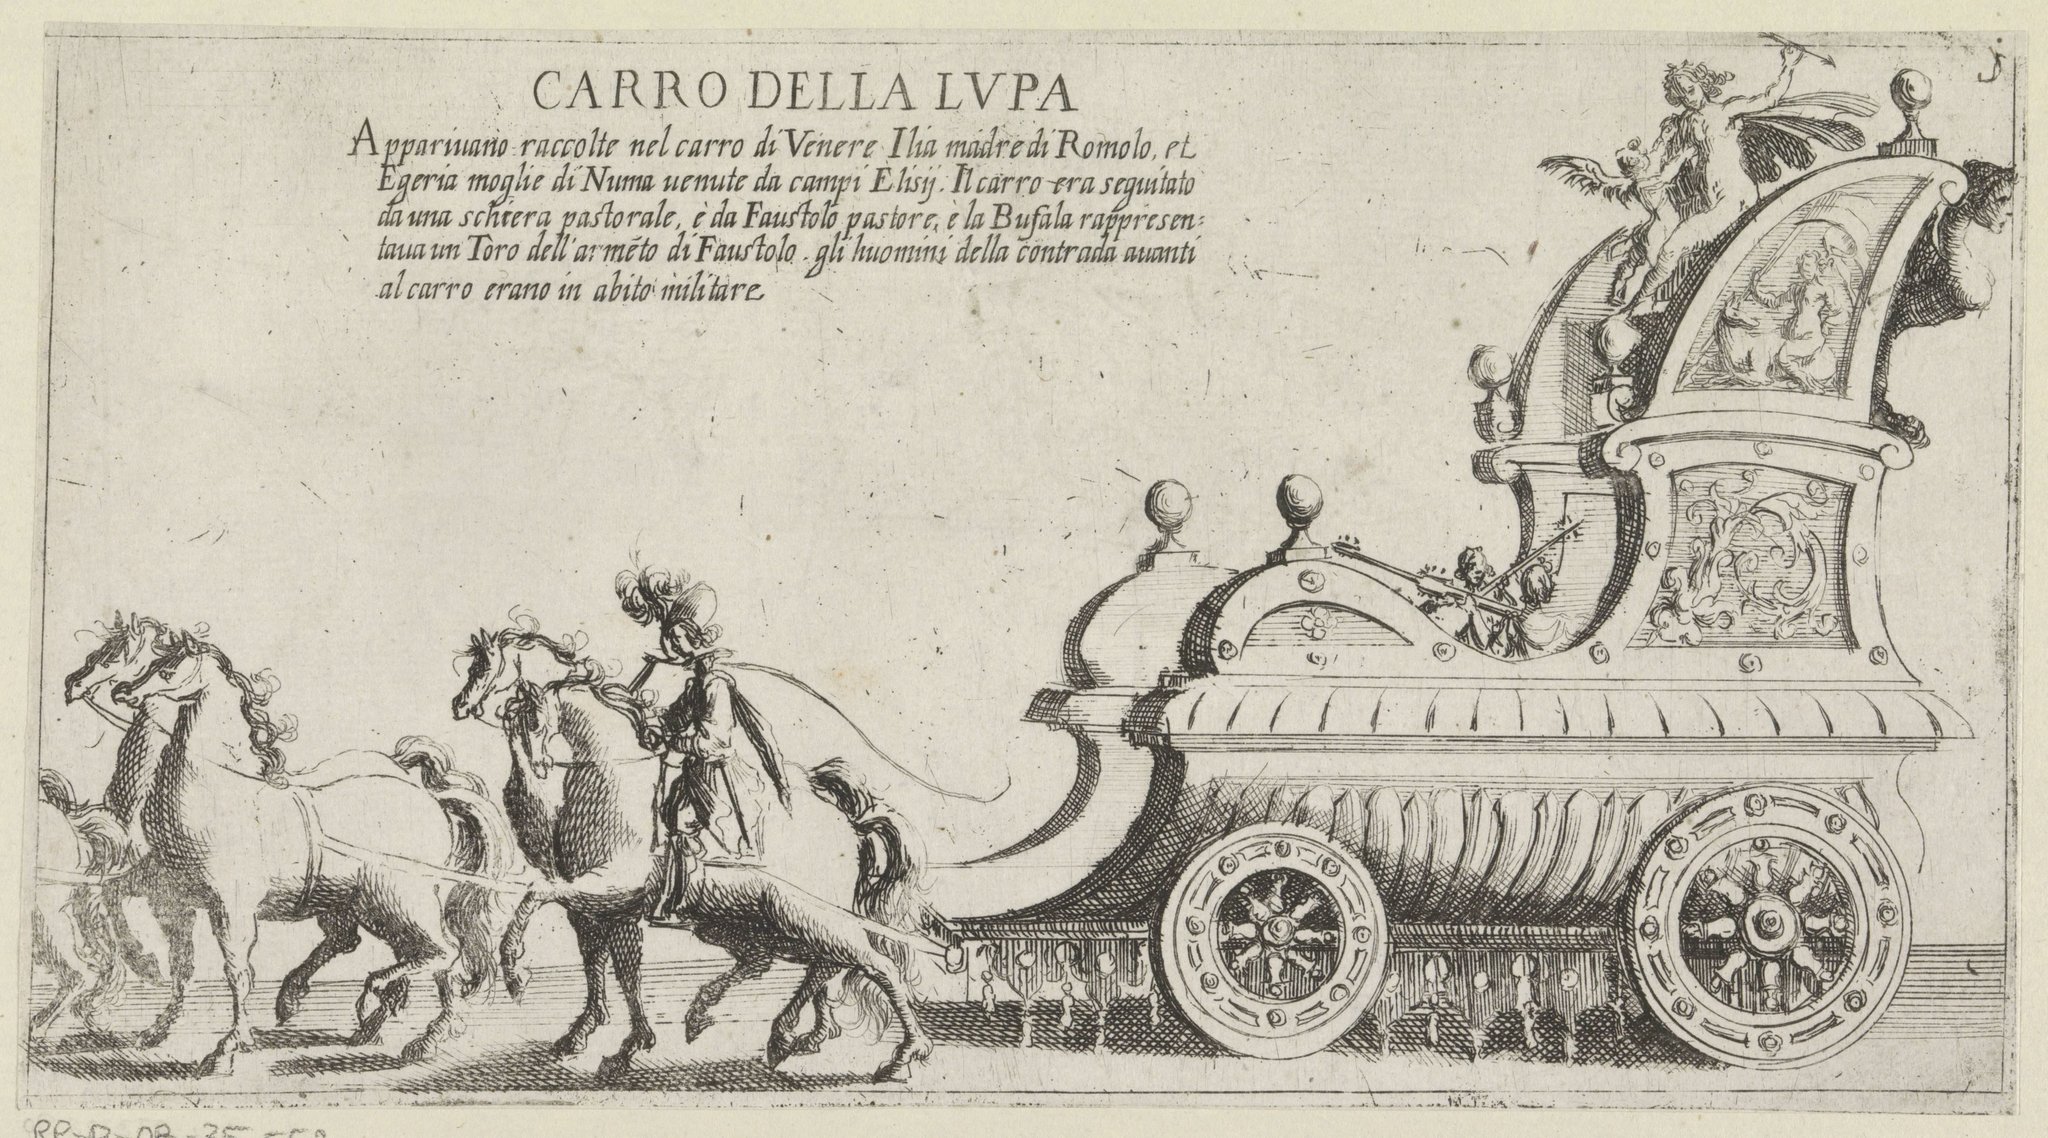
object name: print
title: Triomfwagens voor een festival in Siena in 1632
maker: bernardino capitelli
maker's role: print maker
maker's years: 1589-1640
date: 1632-1640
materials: paper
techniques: etching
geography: italy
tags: chariot, triumphal car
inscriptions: collector's mark: Lugt 240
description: De Triomfwagen van het Sienese district Lupa die wordt getrokken door tenminste zes paarden. Bovenop de wagen staan twee gevleugelde figuren.